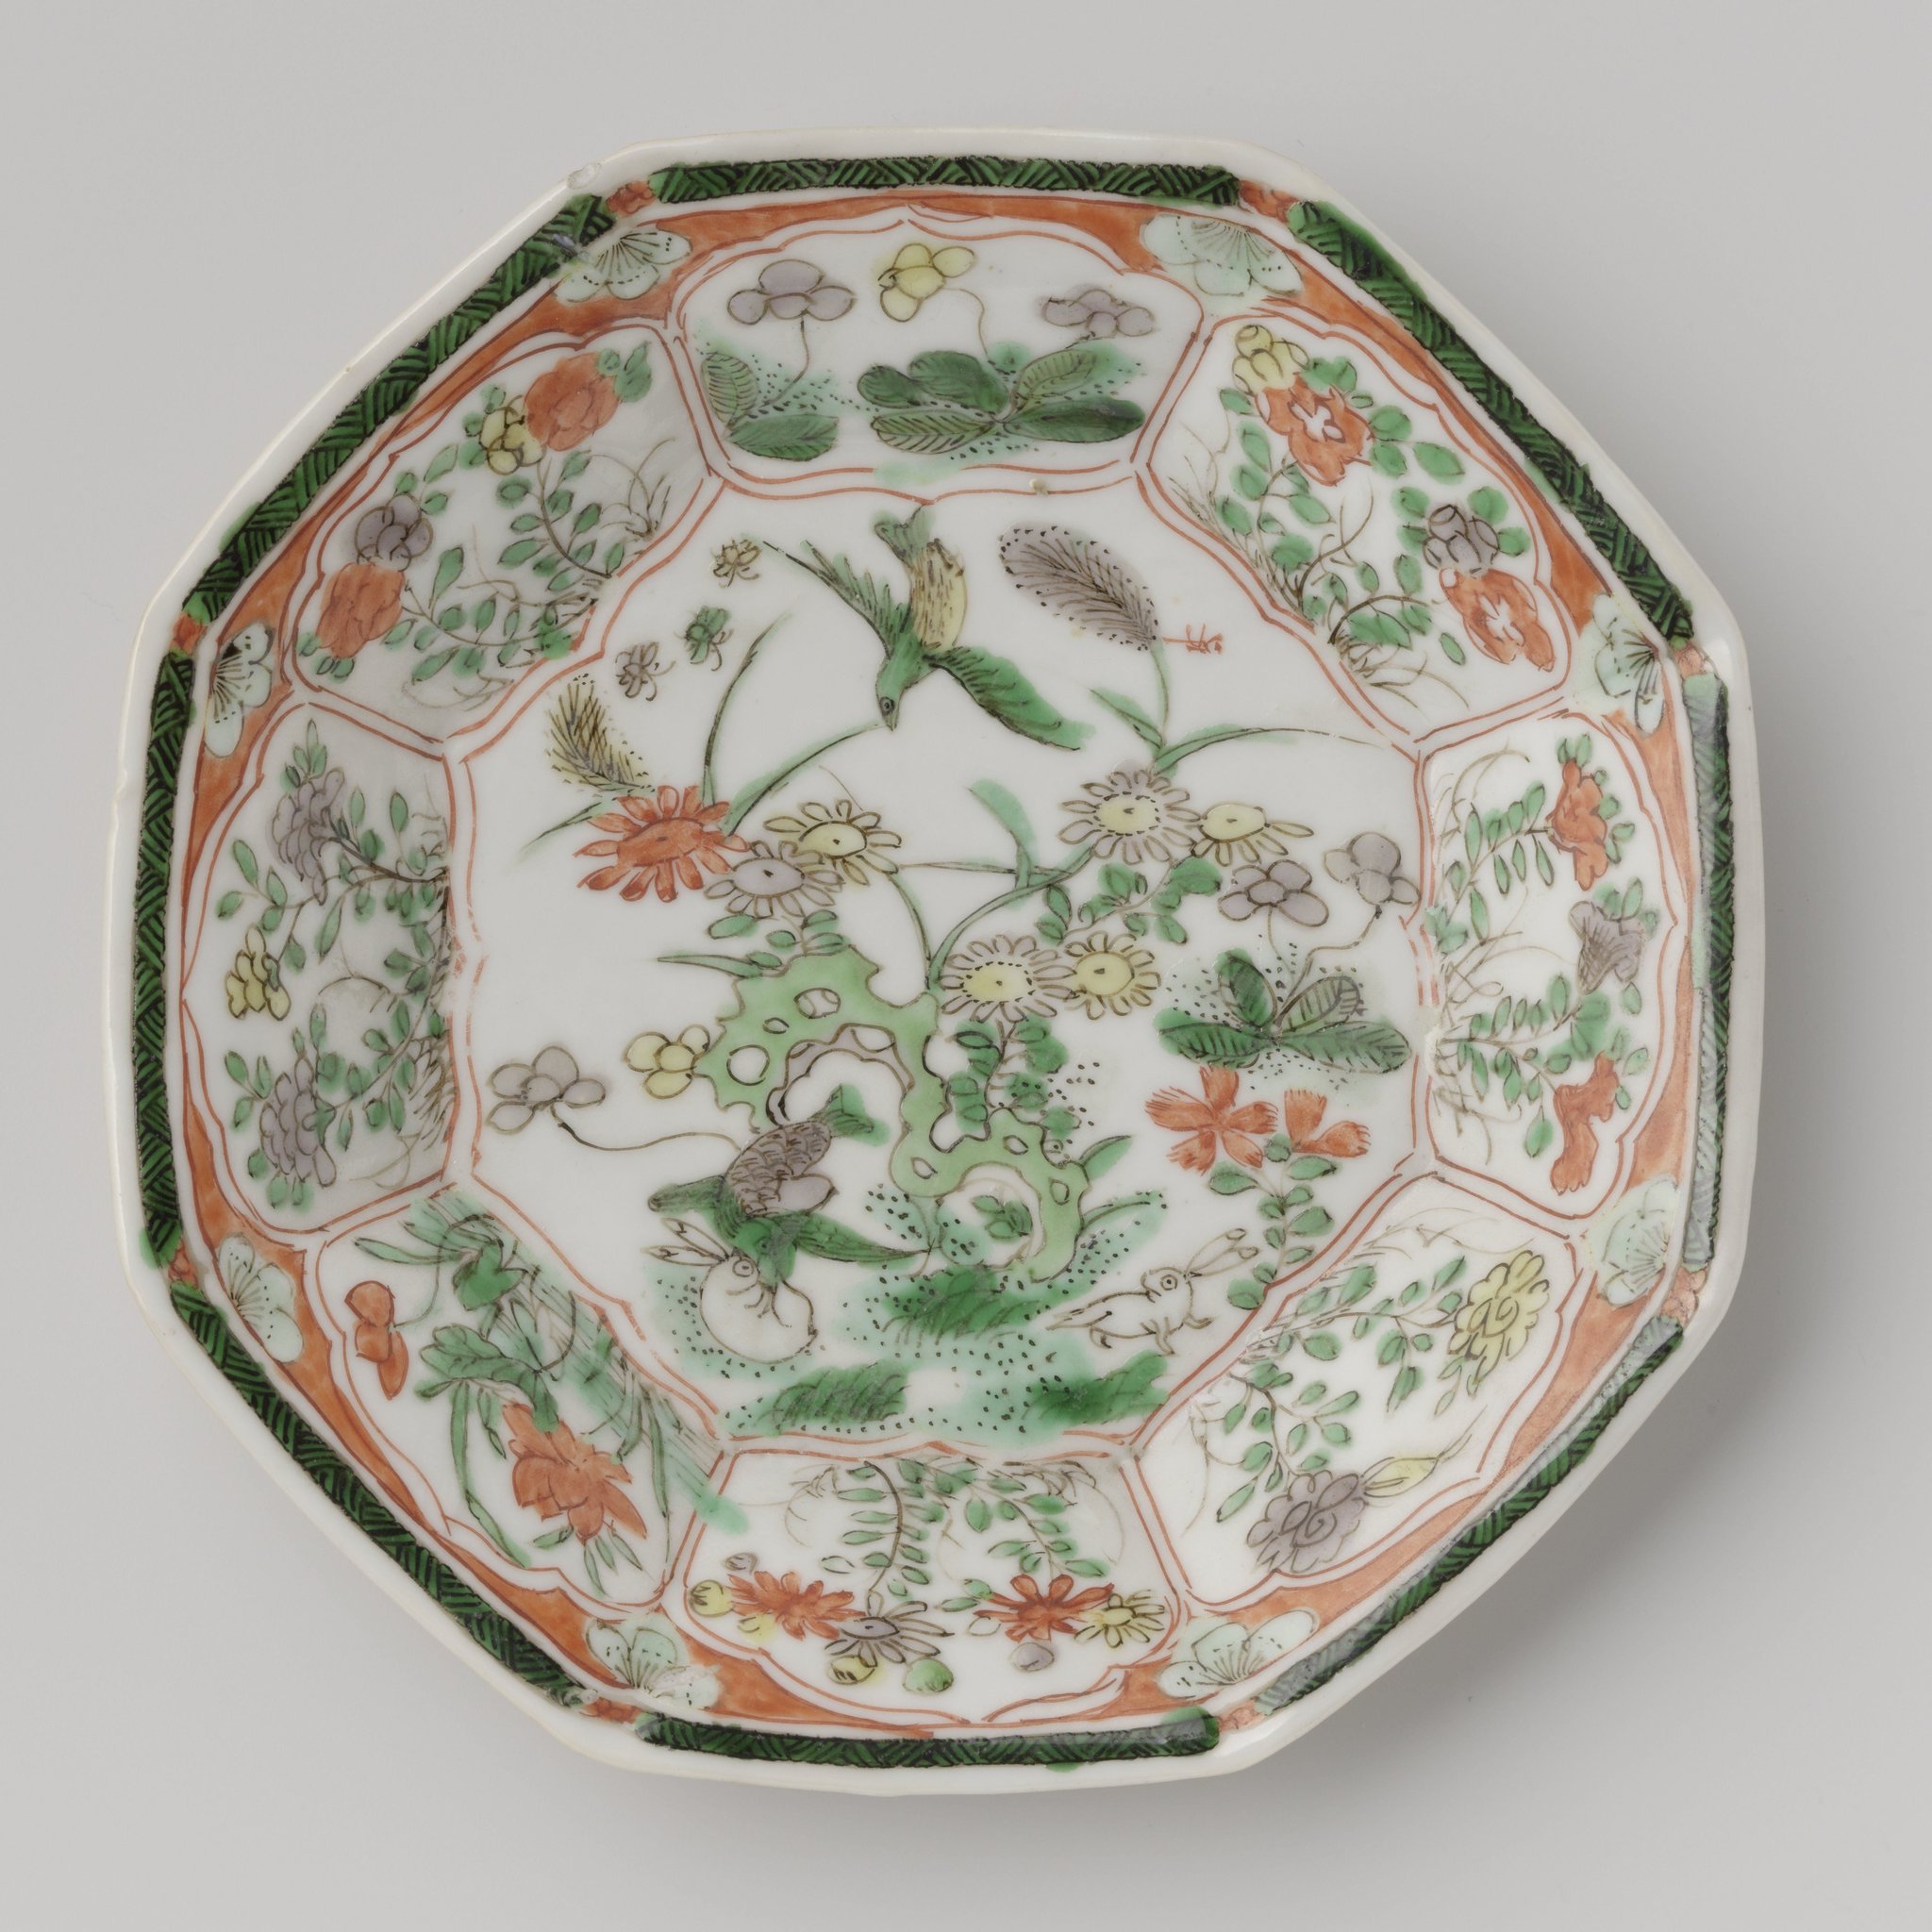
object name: platter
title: Octagonal saucer with light brown, animals and flower sprays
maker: Anonymous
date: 1700-1724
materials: cobalt, glaze, paint, porcelain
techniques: firing, forming, turning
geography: china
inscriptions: mark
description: Kop en schotel, achtkantig, cafe-au-lait, famille verte, met decors van bloeiende planten, haasjes en vogels. Op de buitenzijde zijn op een zeemleerkleurig fond bloempjes in afstekende kleuren aangebracht.